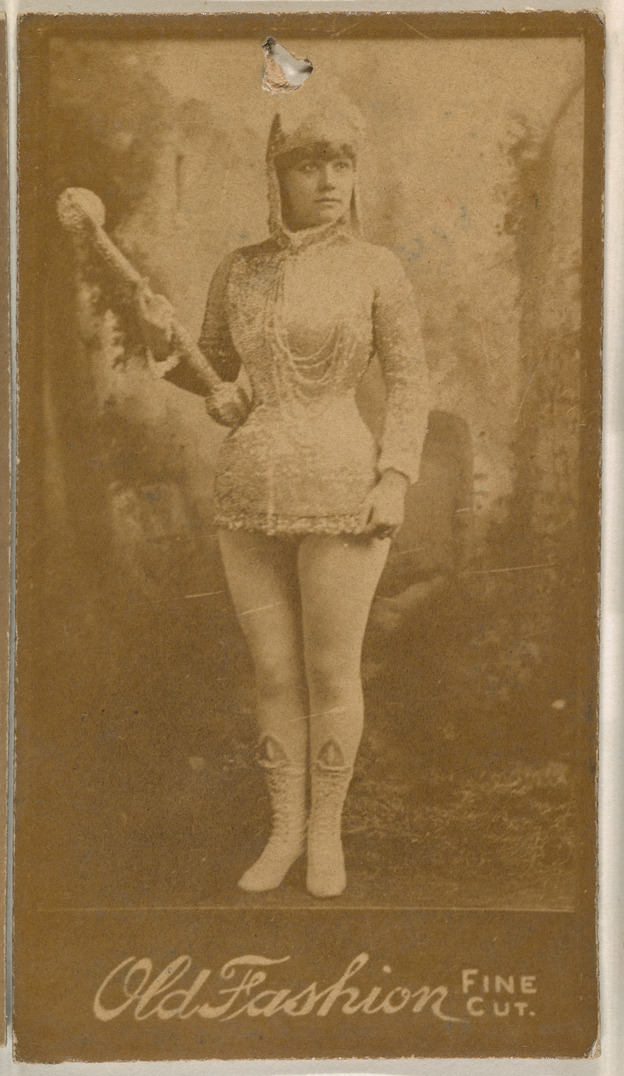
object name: photograph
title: Portrait of actress, from the Actresses series (N664) promoting Old Fashion Fine Cut Tobacco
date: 1888-1890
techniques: albumen silver print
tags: portraits,women,actresses